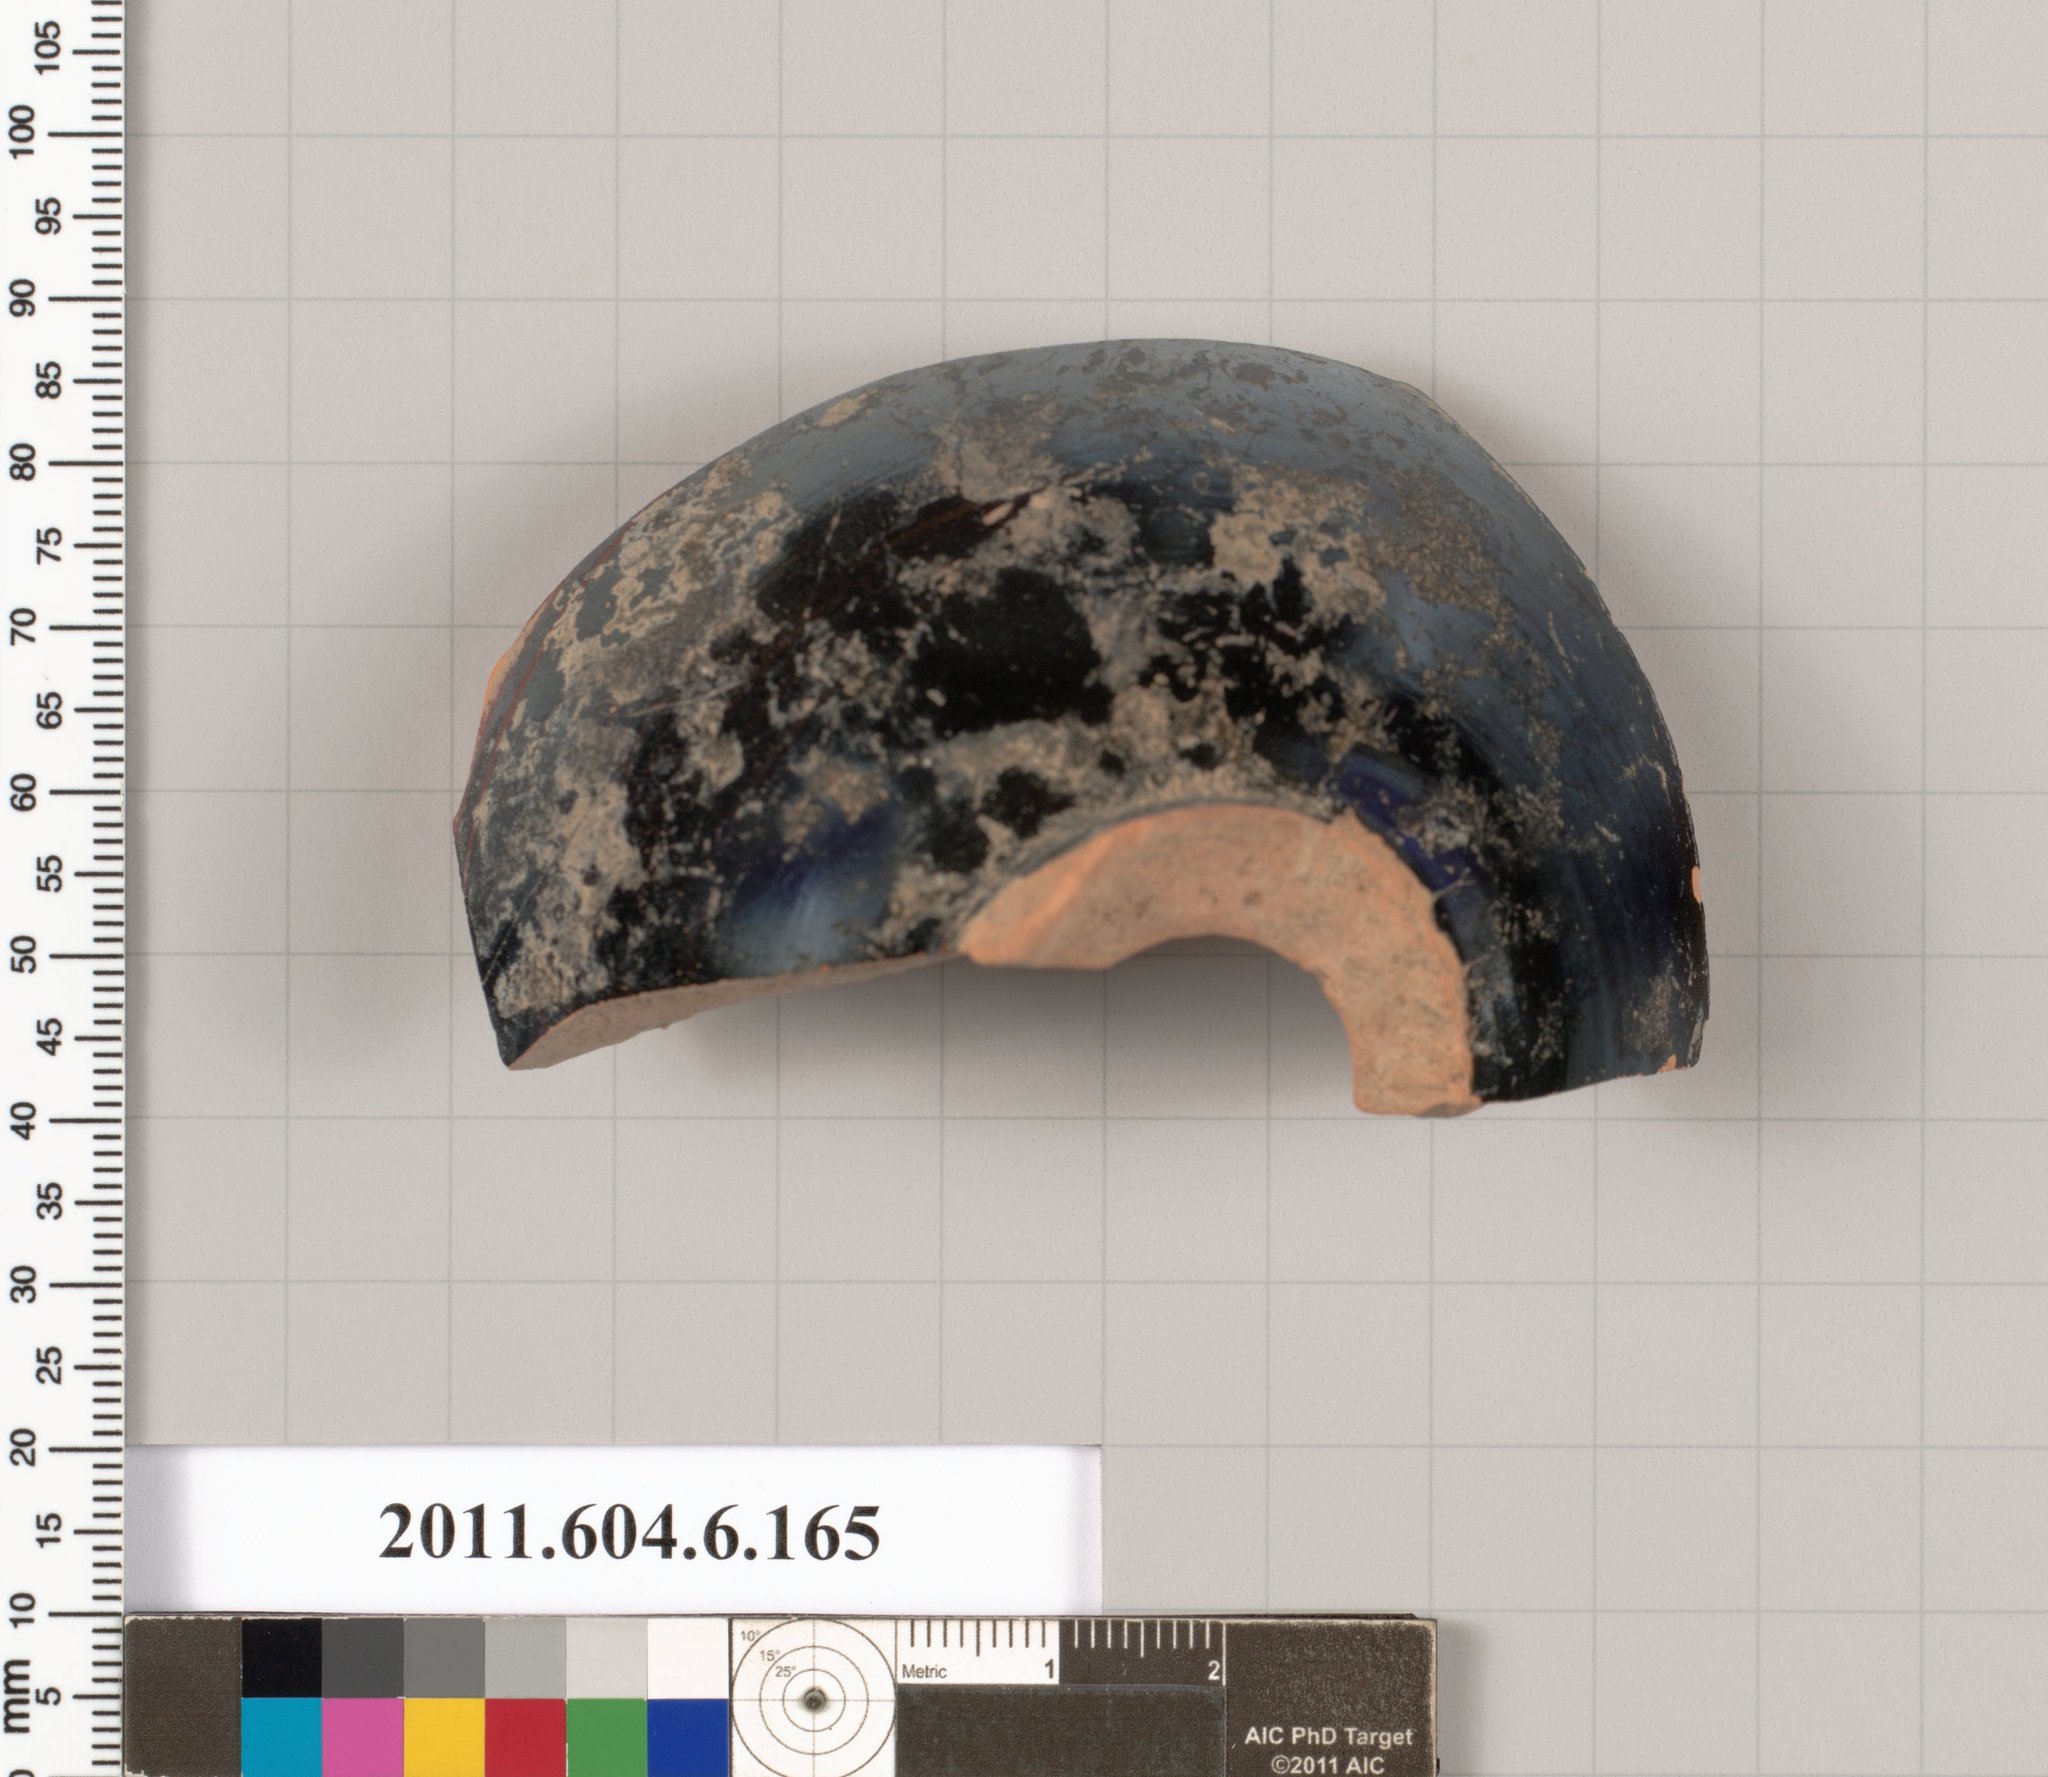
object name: squat lekythos fragment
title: Terracotta fragment of a squat lekythos (oil flask)?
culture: greek, attic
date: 500-401 BCE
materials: terracotta